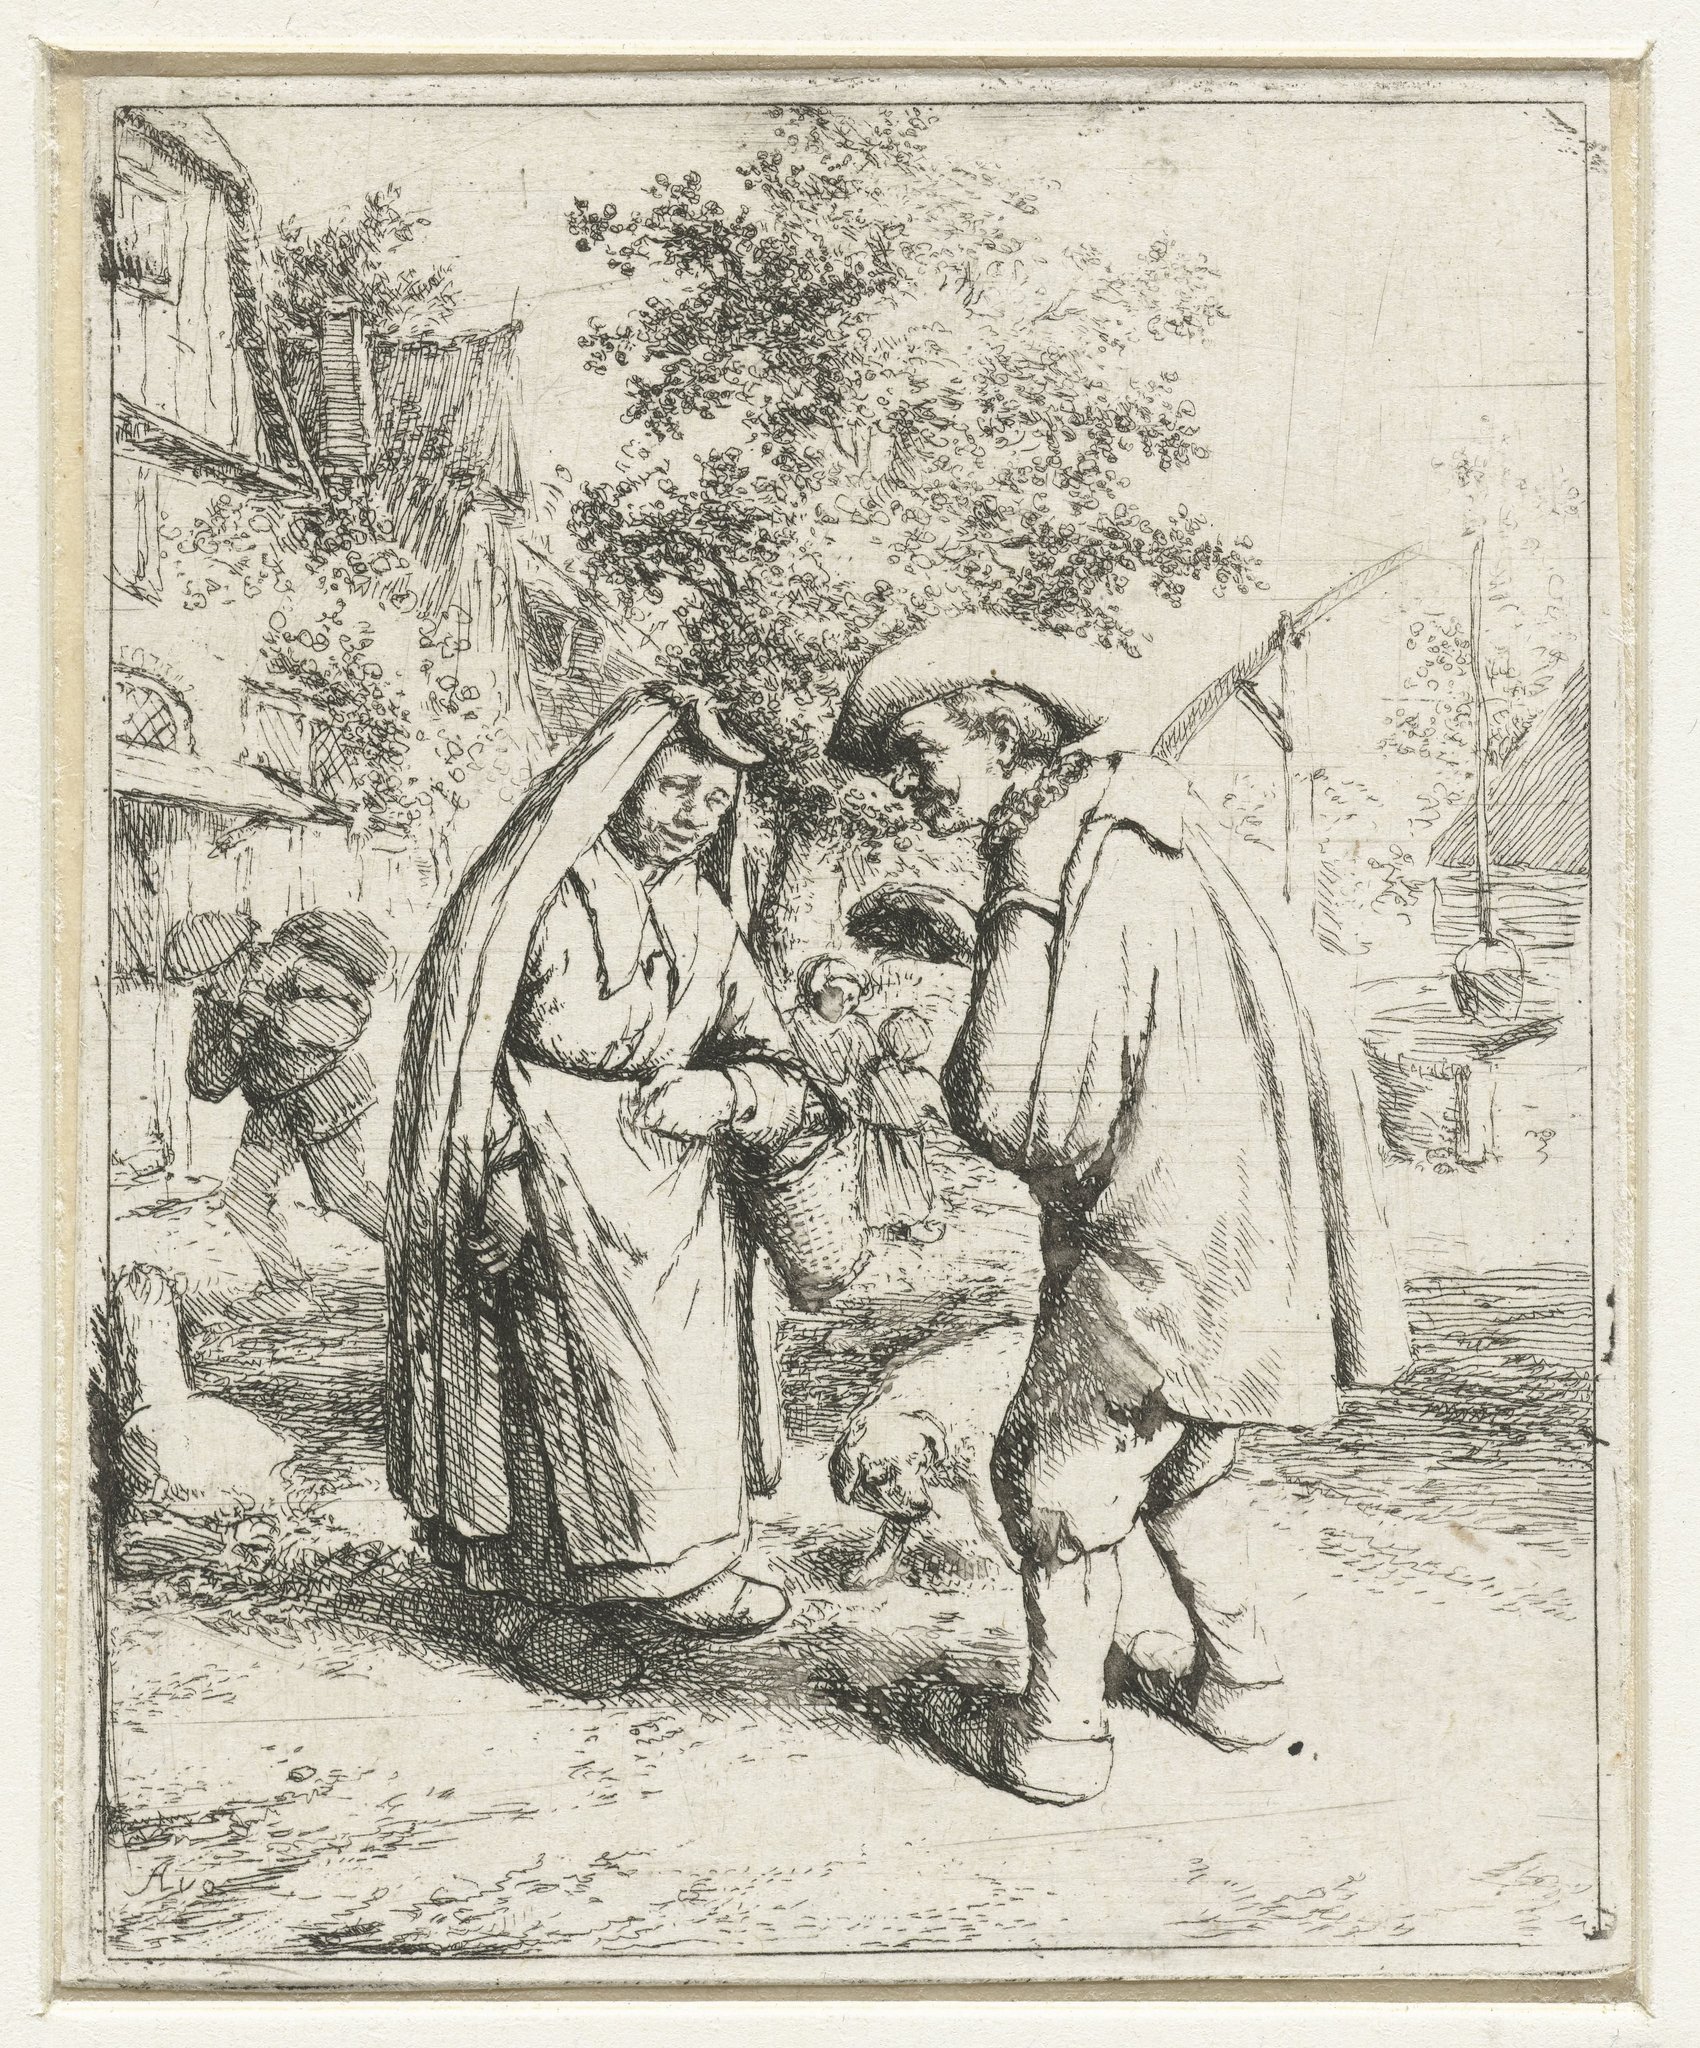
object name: print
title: Het gesprek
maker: adriaen van ostade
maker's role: draughtsman, painter, print maker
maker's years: 1610-1685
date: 1646-1650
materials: paper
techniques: etching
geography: haarlem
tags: female sex; woman, conversation, dialogue; conversation piece, male sex; man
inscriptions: collector's mark: Lugt 240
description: Een man en vrouw zijn met elkaar in gesprek in een dorp. De vrouw draagt over haar boerenkleding een huikje.